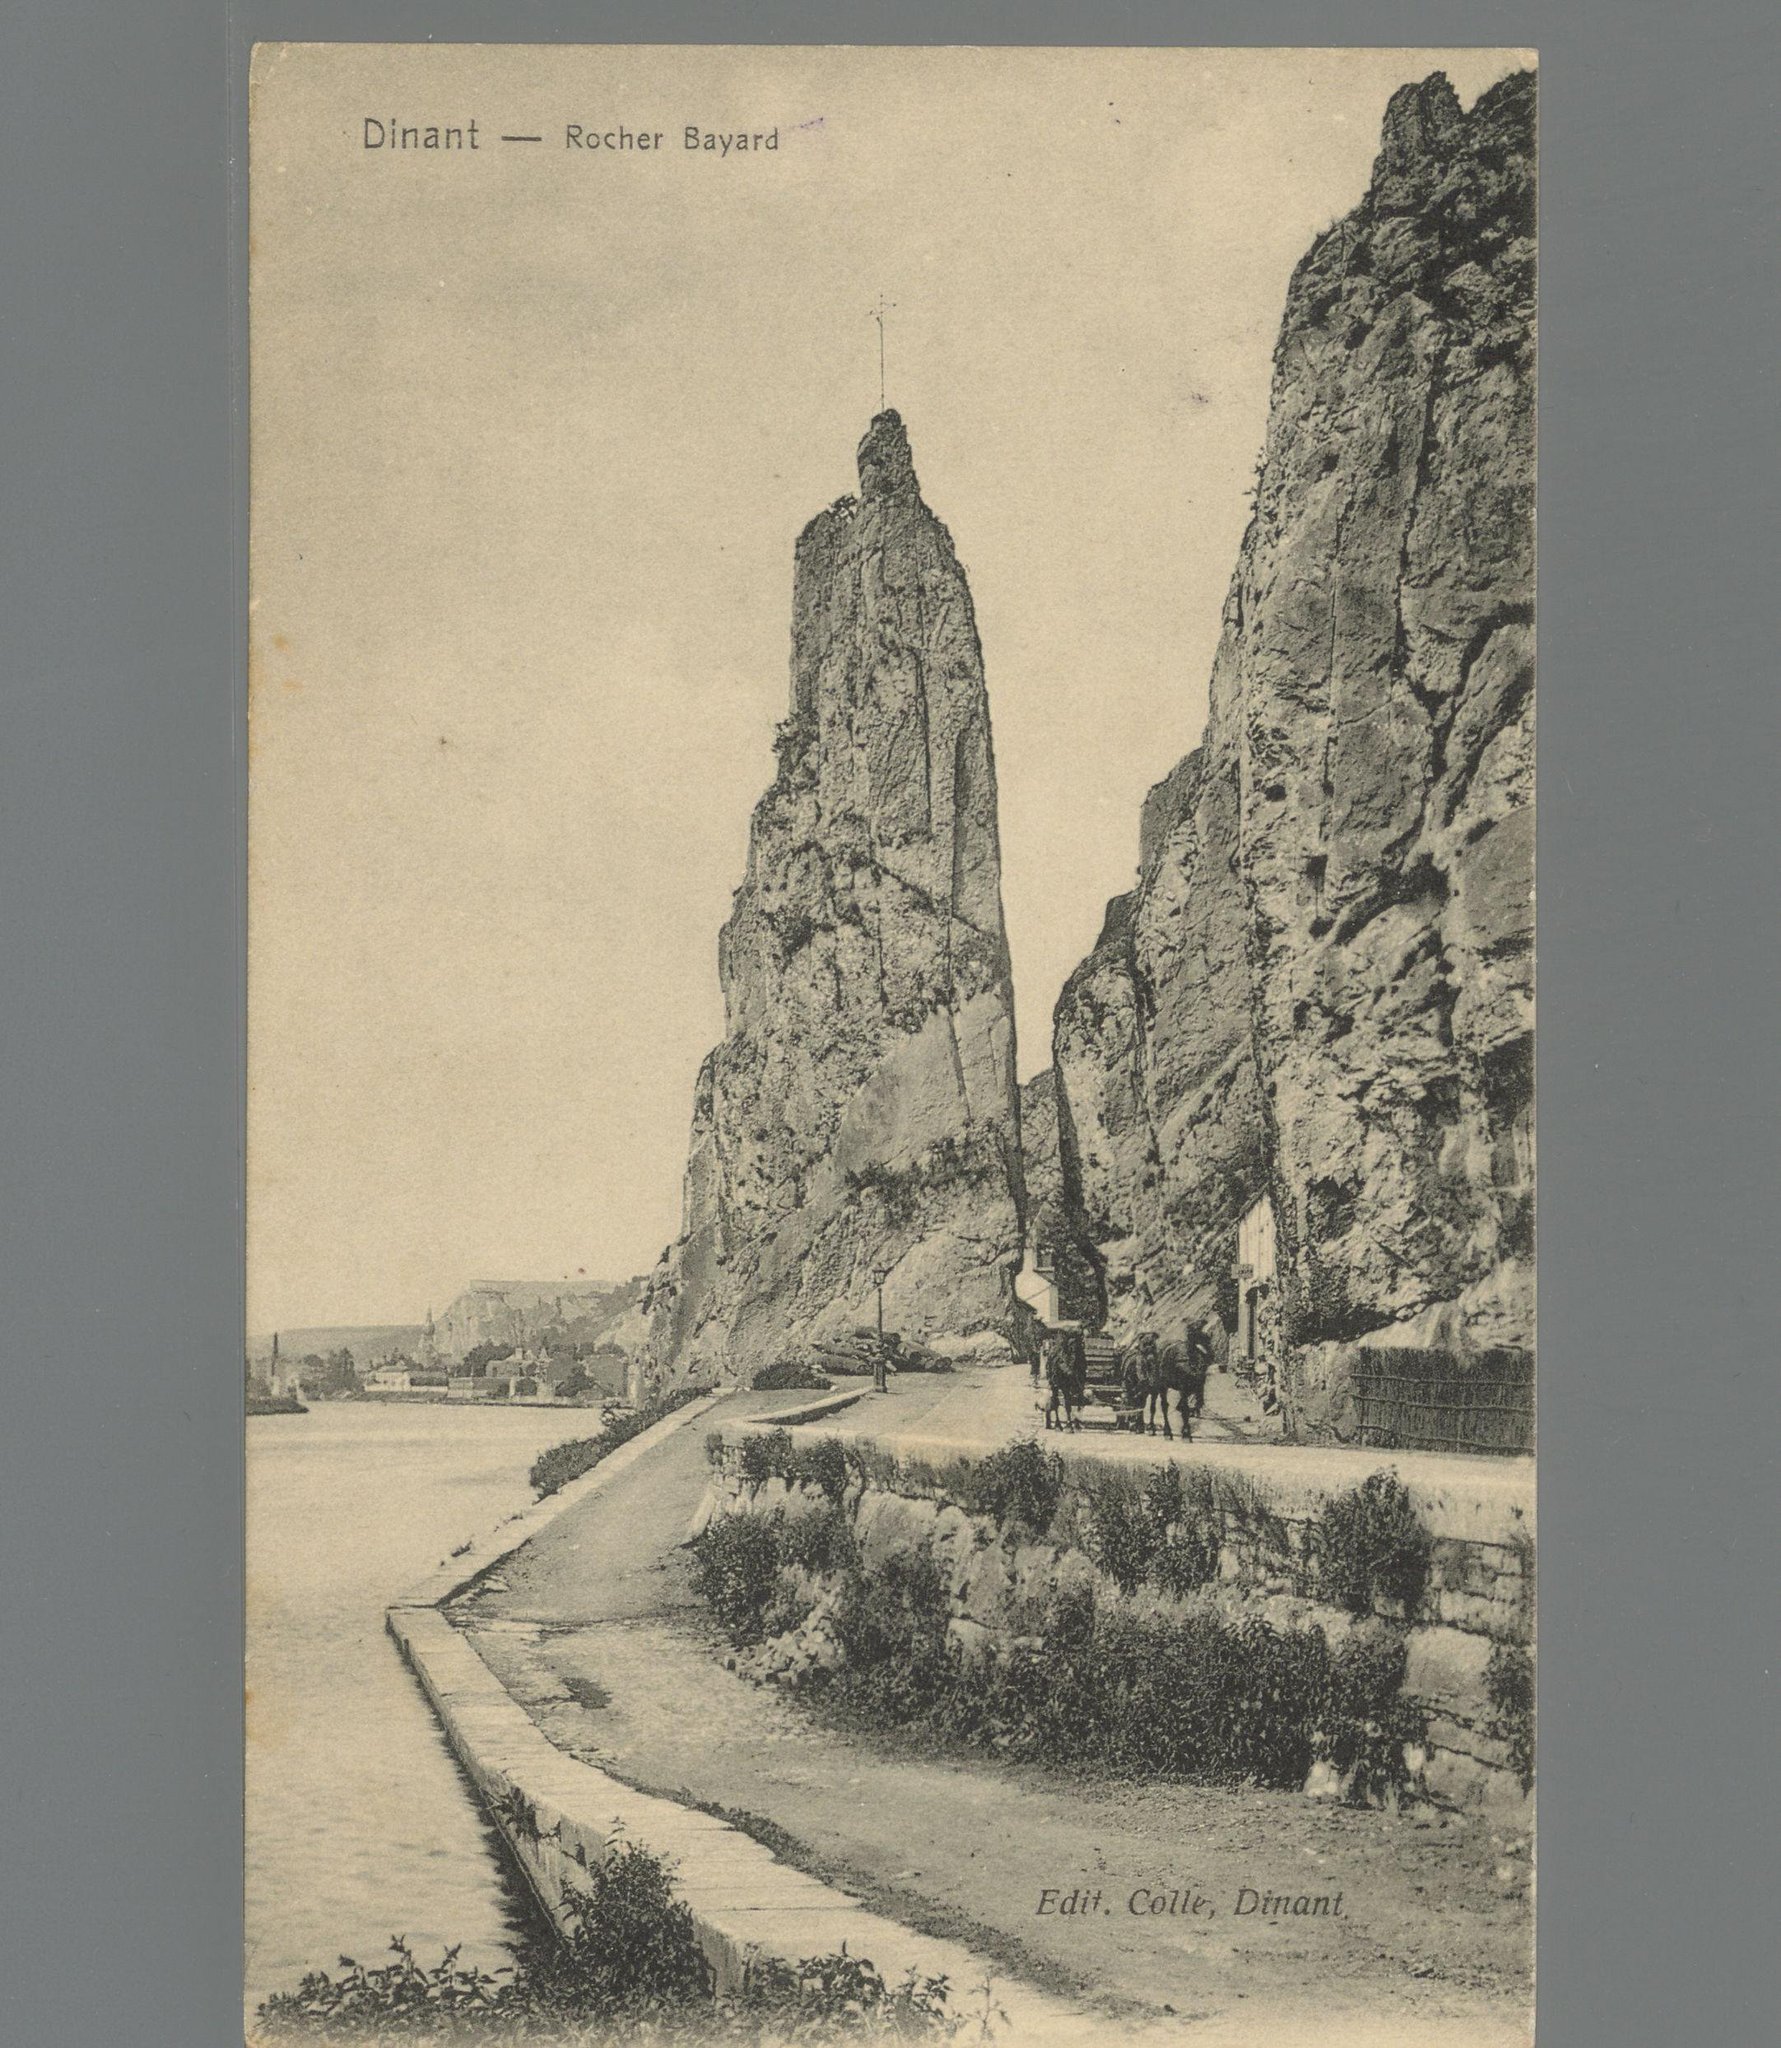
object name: photomechanical print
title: Dinant. Rocher Bayard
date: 1906-1930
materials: cardboard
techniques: photograph, writing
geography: dinant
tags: rock-formations, river (+ landscape with figures, staffage)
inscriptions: poststempel, verso, gestempeld